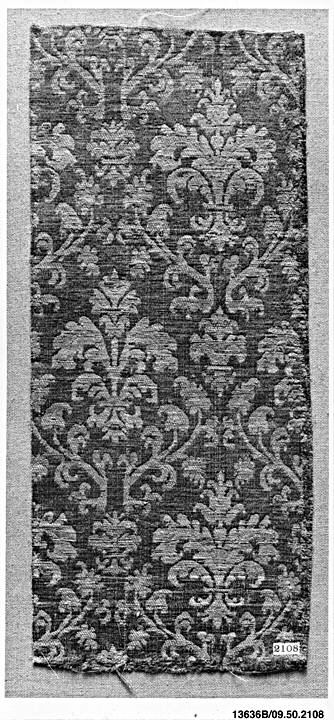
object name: piece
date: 1501-1600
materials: hemp, silk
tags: leaves